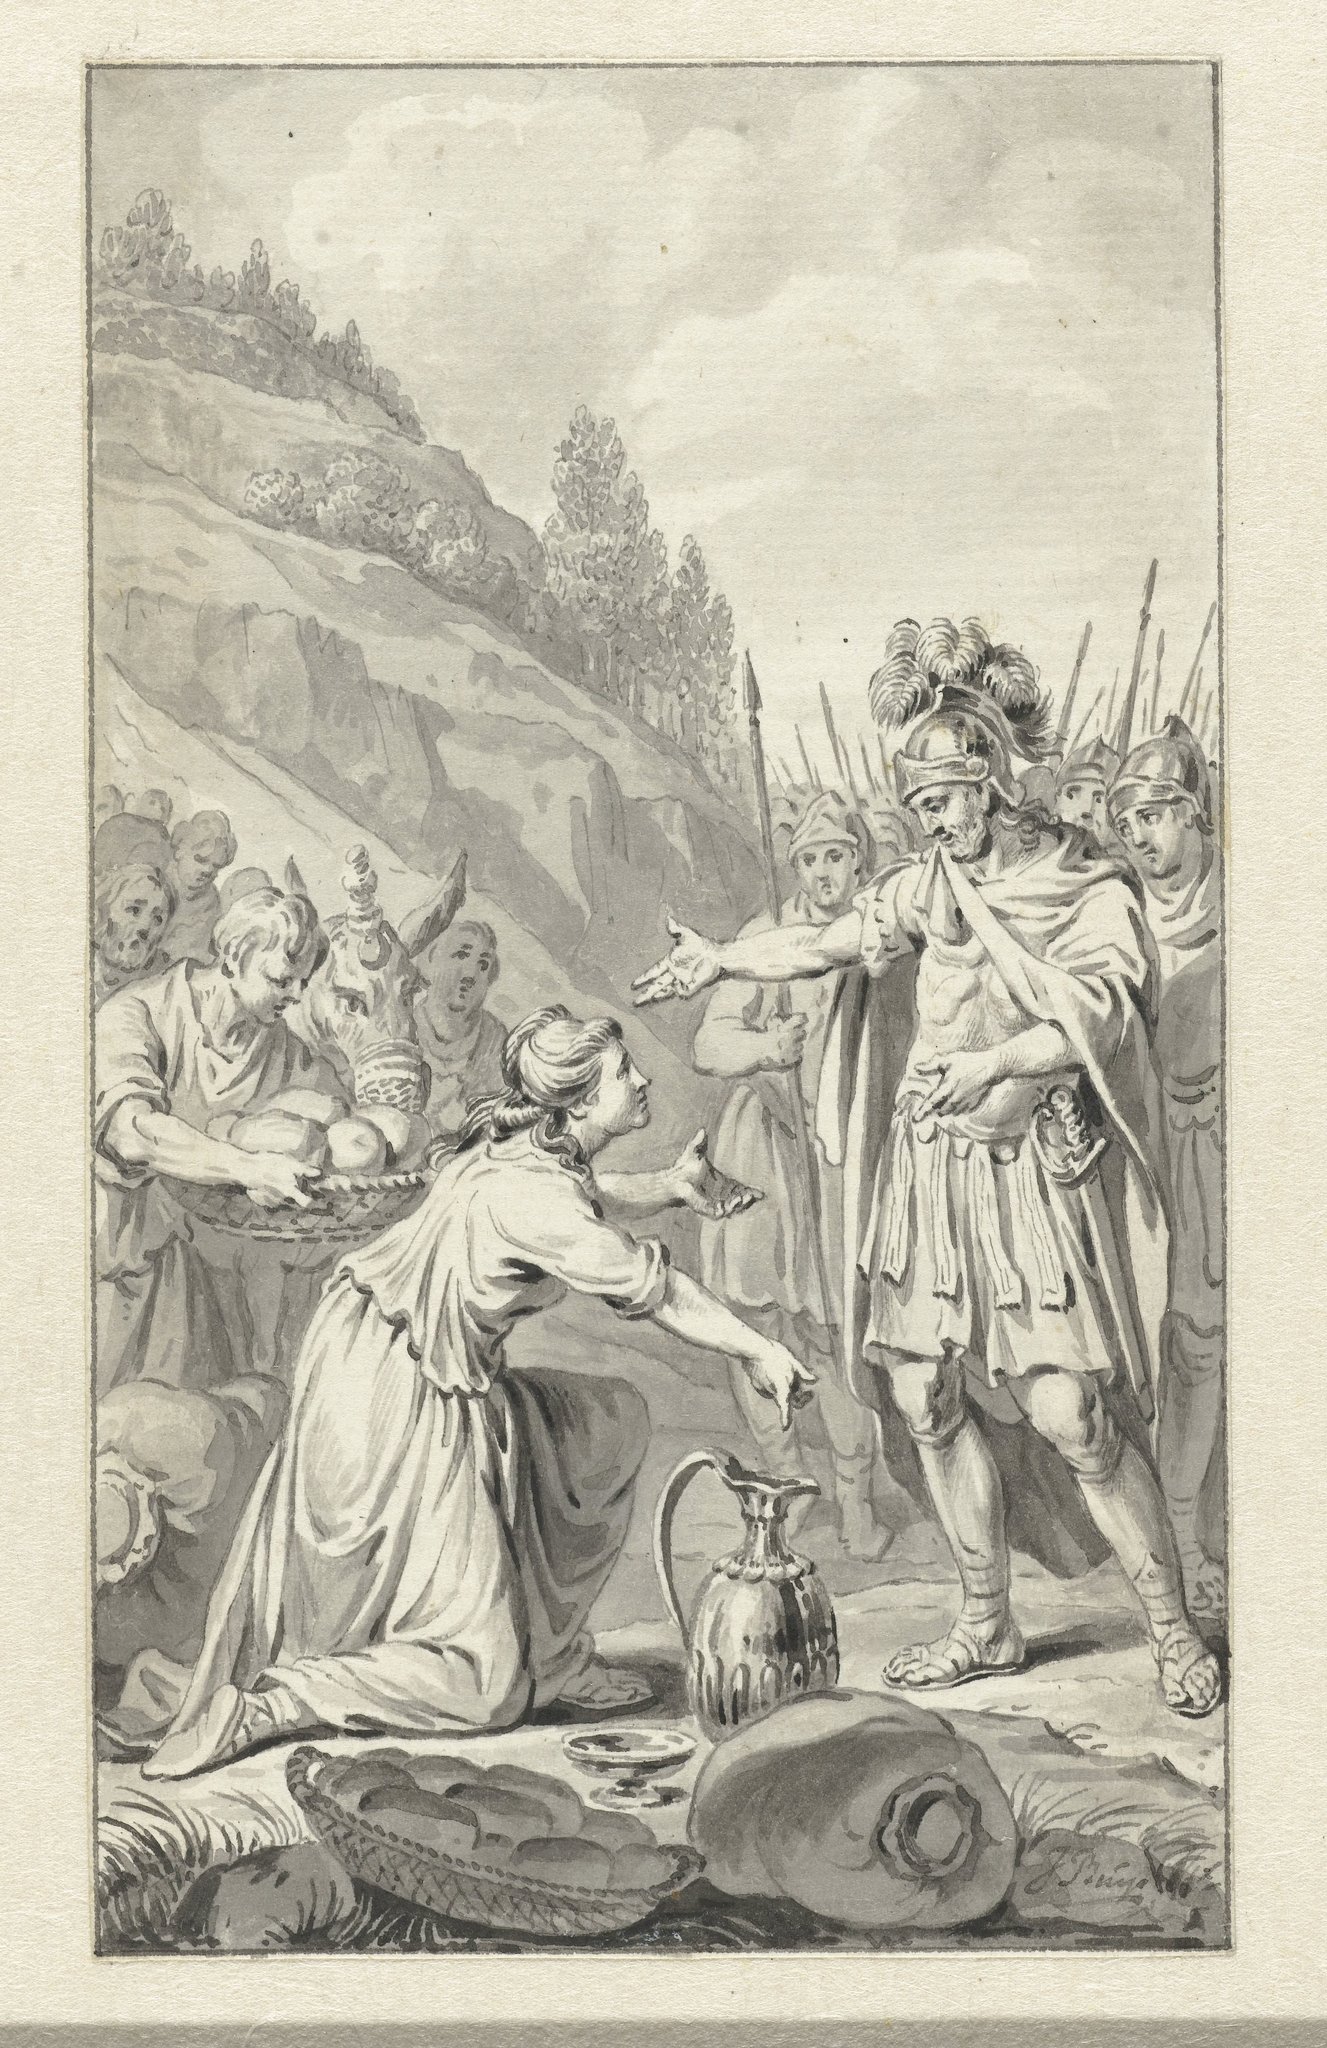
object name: drawing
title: David en Abigaïl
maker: jacobus buys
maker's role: draughtsman, print maker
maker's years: 1724-1801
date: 1734-1801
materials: ink, paper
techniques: brush, pen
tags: meeting of david and abigail, who kneels before him